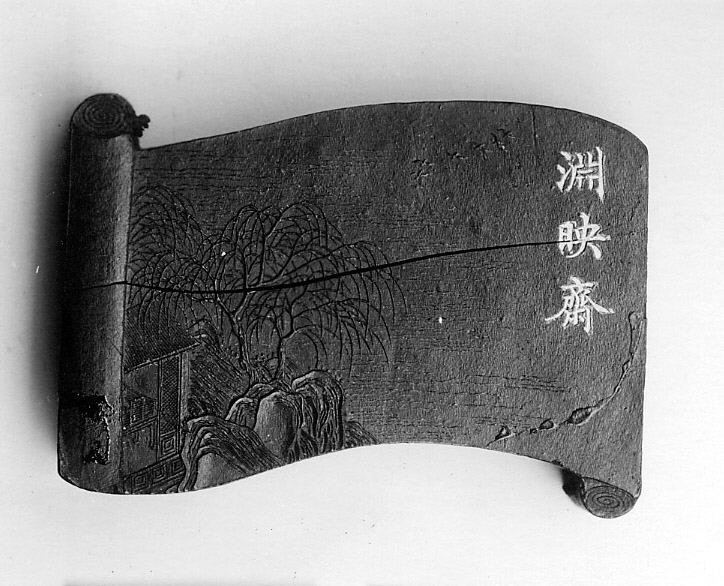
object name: ink tablet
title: Pool Lighted Studio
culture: chinese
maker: jian guzhai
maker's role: artist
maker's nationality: chinese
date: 1867-1933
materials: ink